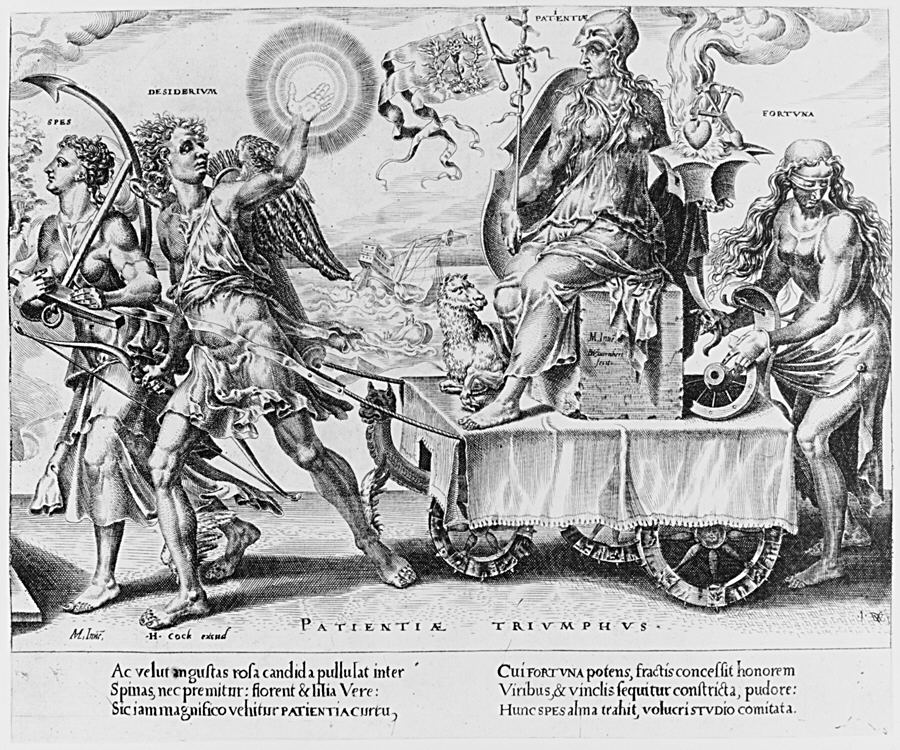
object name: print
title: Triumph of Patience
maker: dirck volckertsz coornhert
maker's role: artist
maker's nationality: netherlandish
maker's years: 1519-1590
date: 1501-1600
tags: animals,weapons,flags